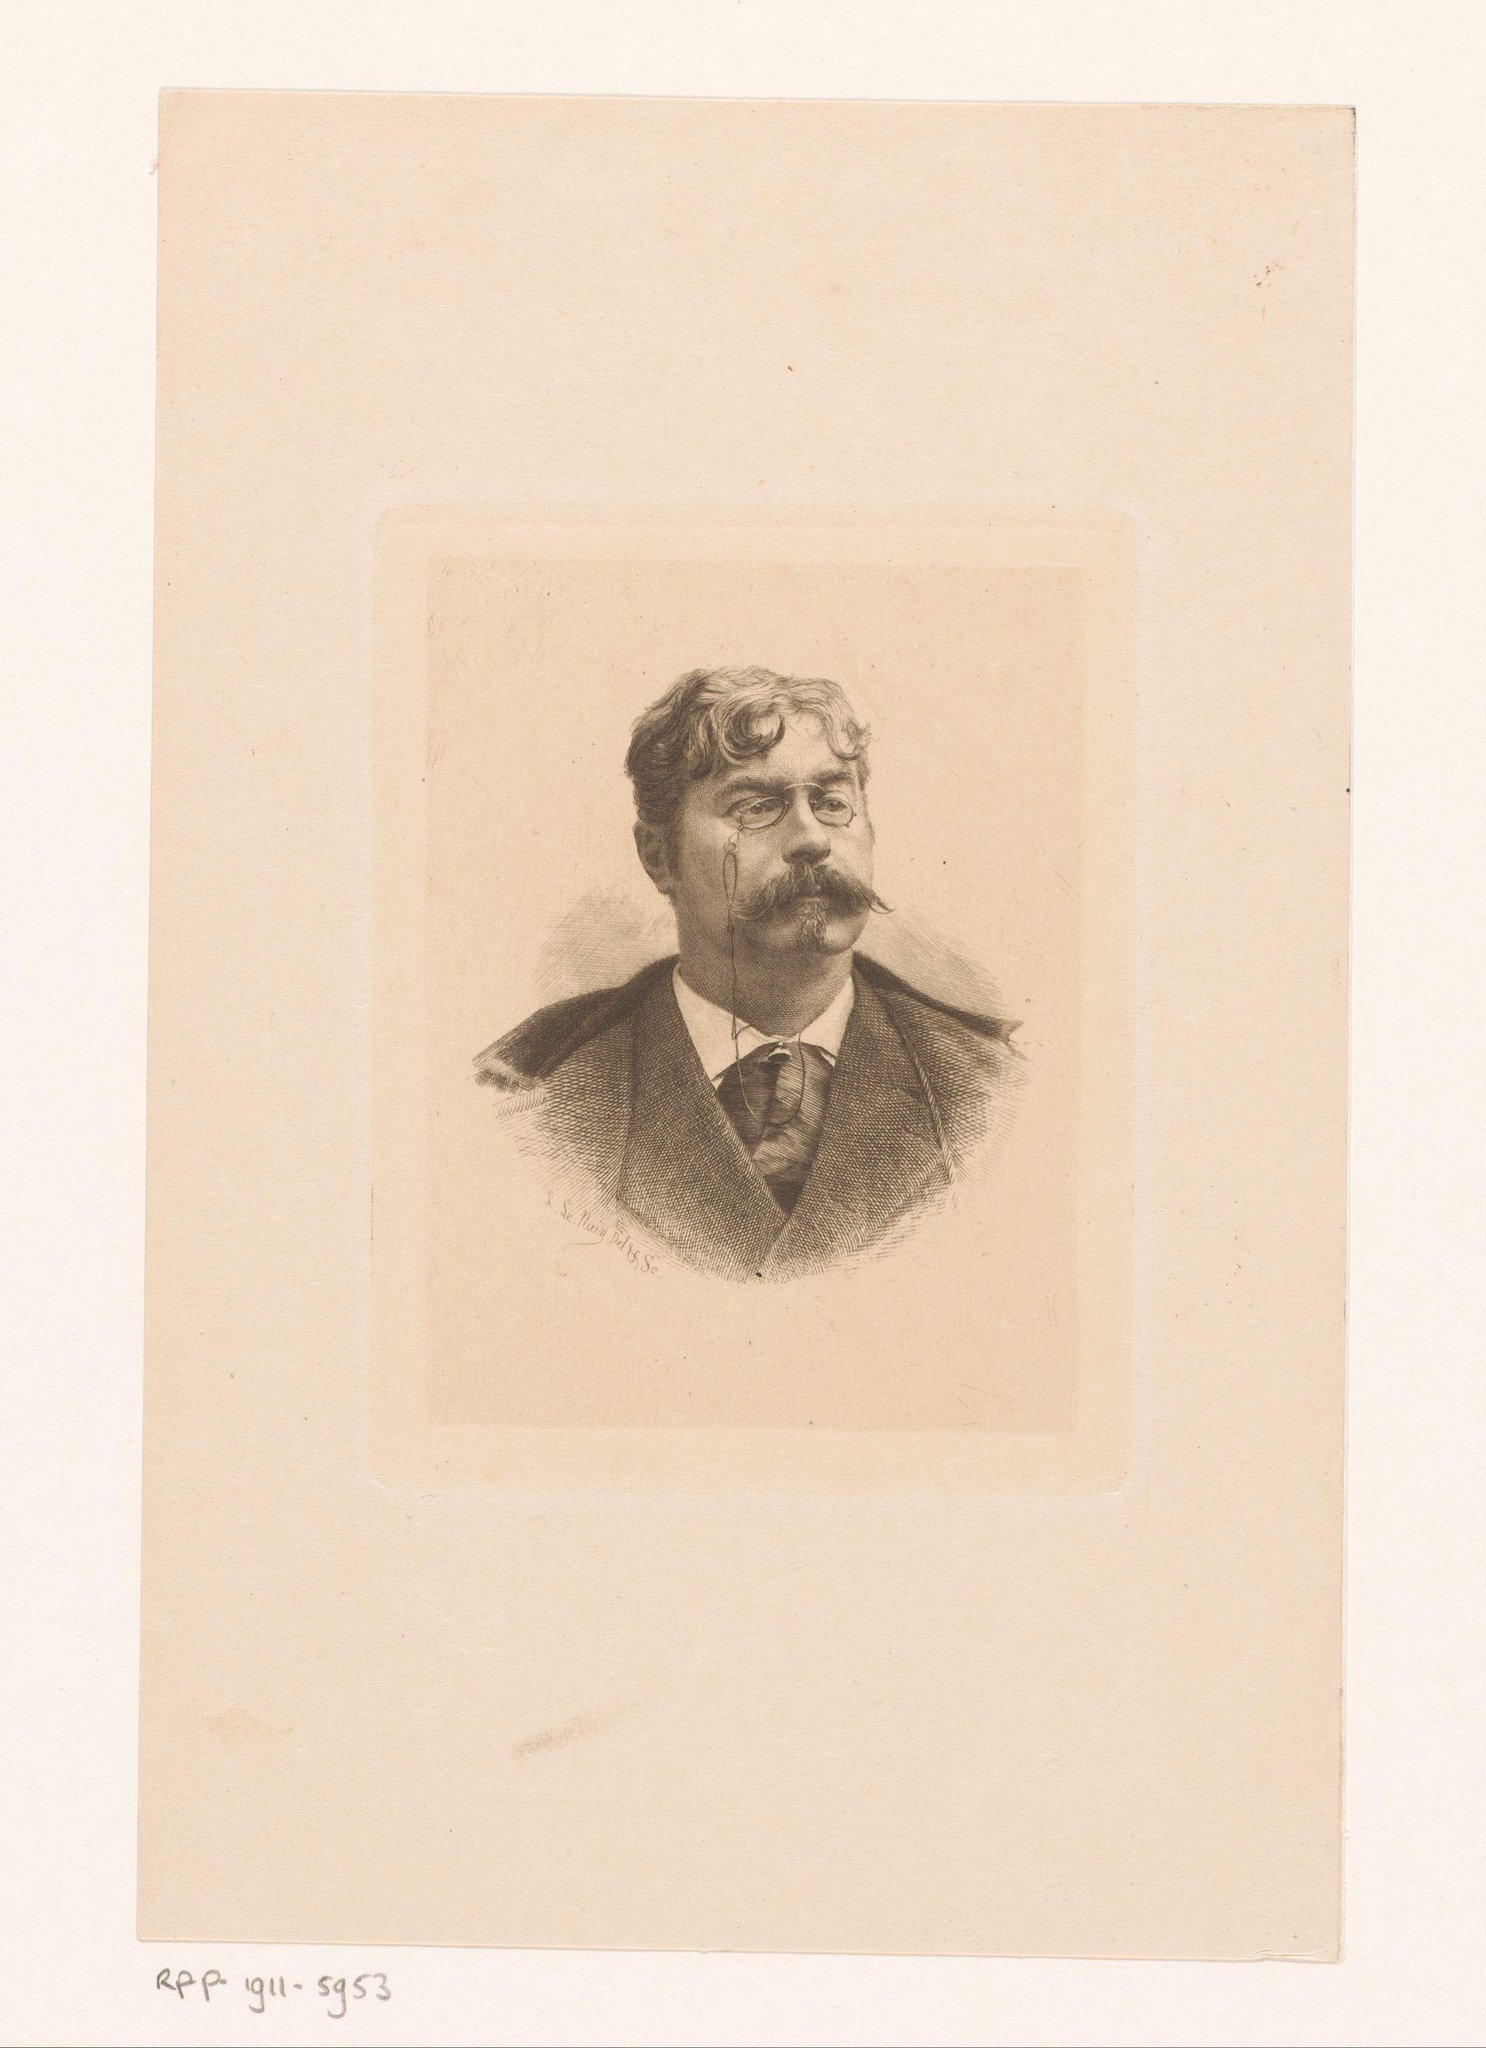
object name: print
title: Portret van Camille Lemonnier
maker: louis le nain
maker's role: print maker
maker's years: 1851-1939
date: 1861-1911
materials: paper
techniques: etching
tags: camille lemonnier, eyeglasses, spectacles, adult man, historical persons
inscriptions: collector's mark: Lugt 2228